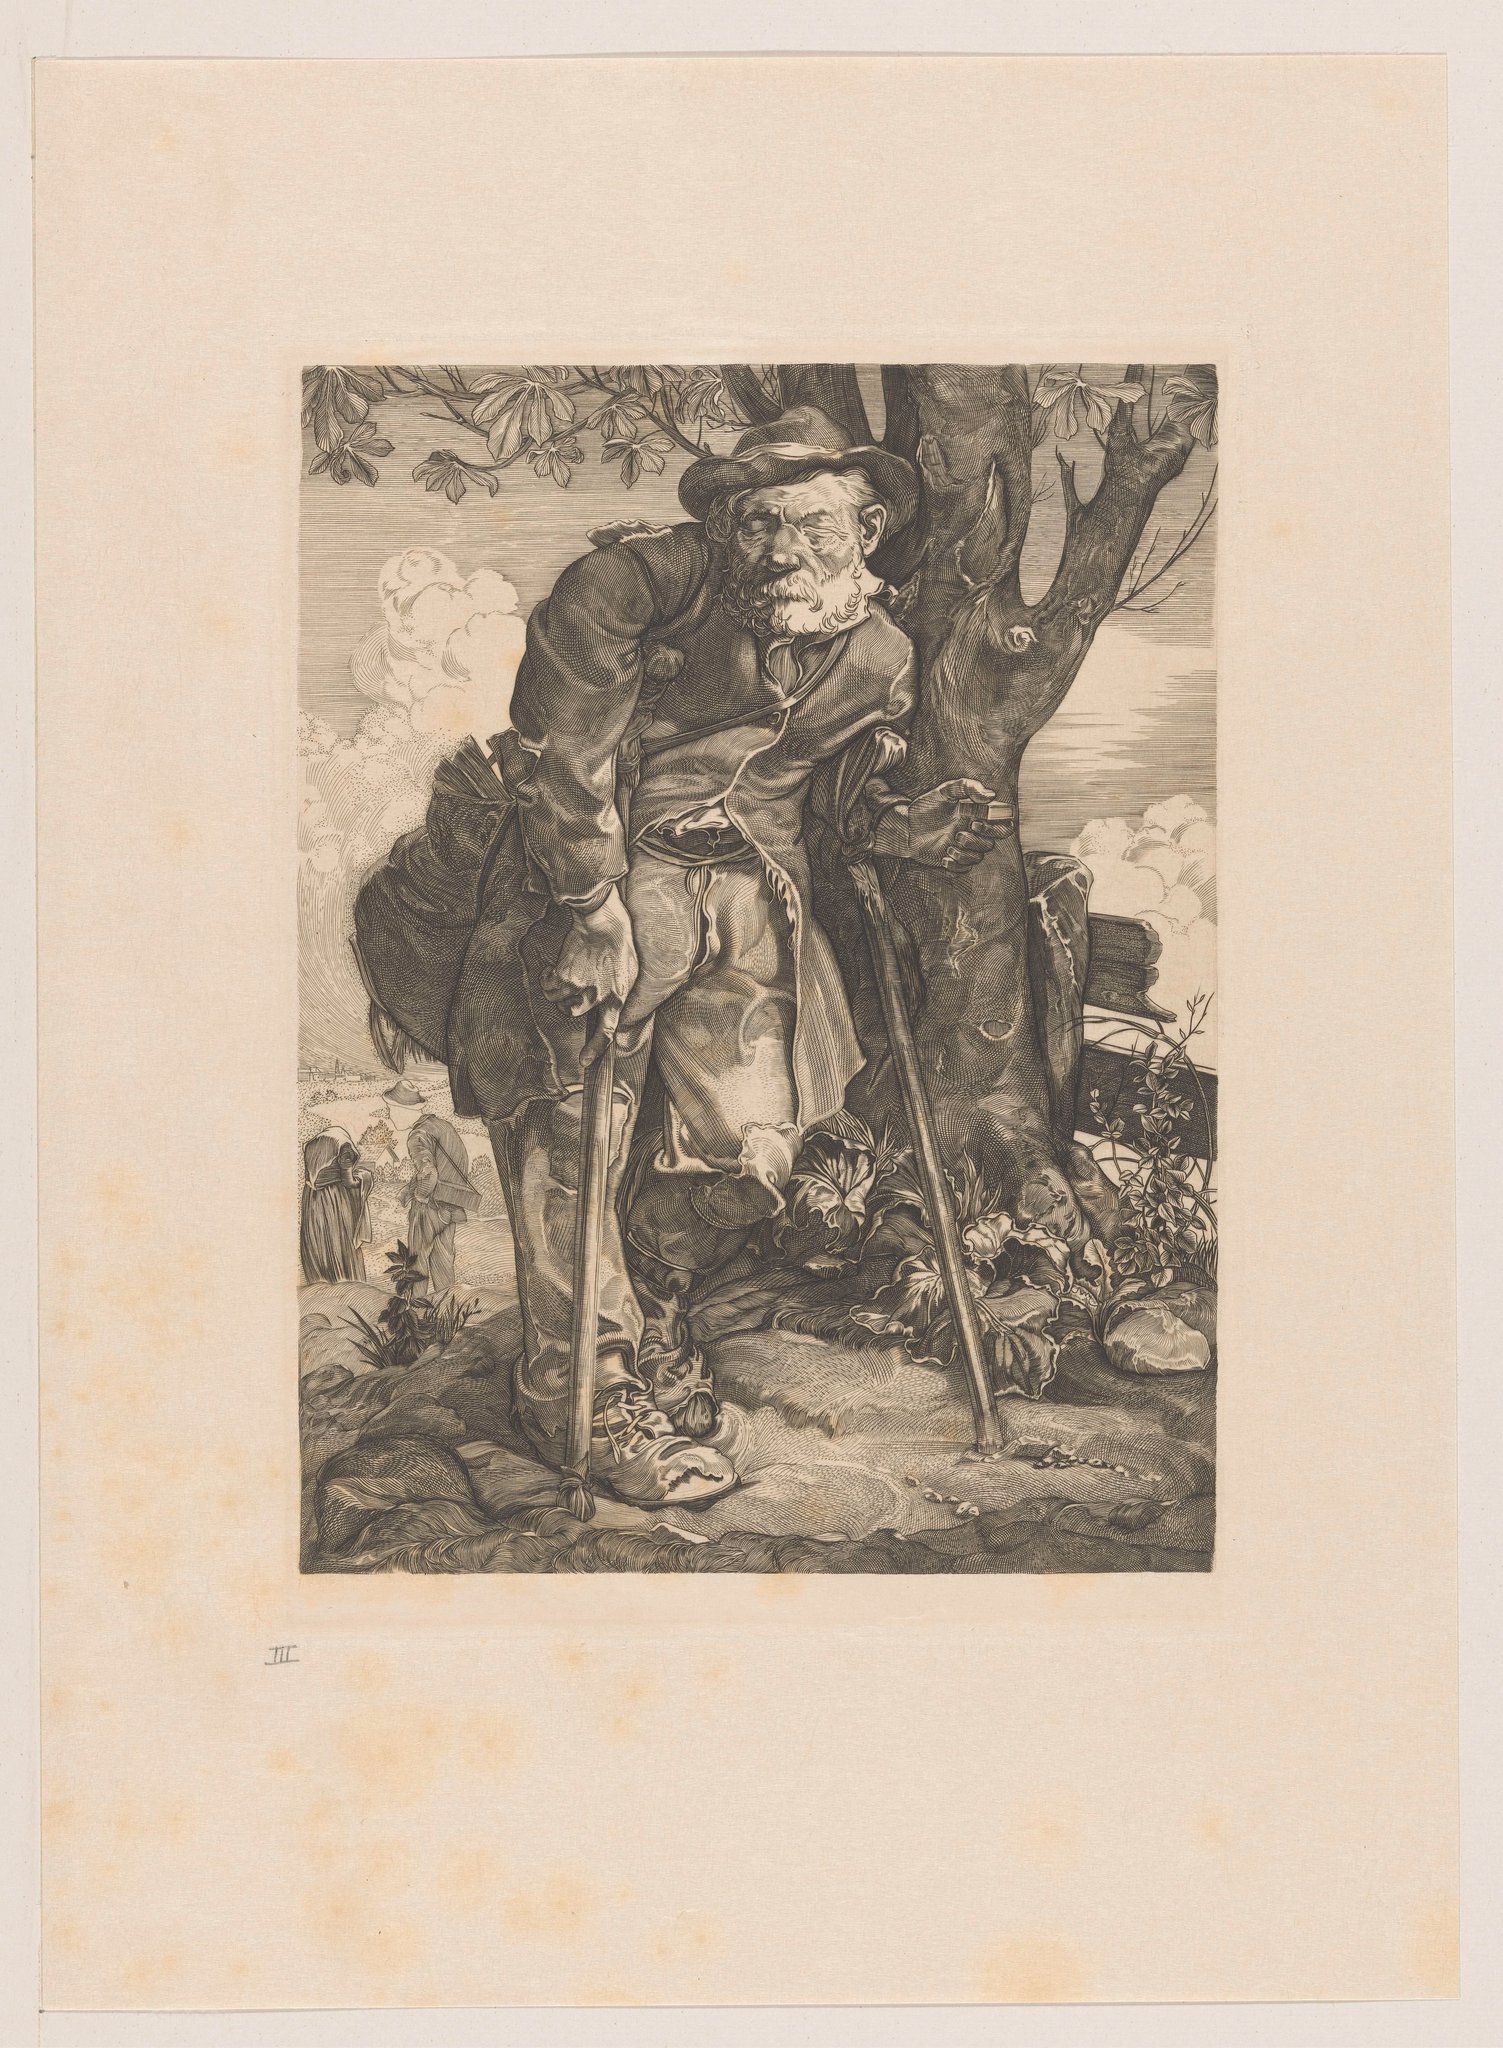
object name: print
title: Landlooper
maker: johannes josephus aarts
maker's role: draughtsman, print maker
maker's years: 1871-1934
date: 1907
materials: paper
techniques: engraving, intaglio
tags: crutches, beggar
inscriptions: collector's mark: Lugt 2166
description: Een bebaarde man met hoed, gekleed in beschadigde, deels herstelde kleren, lopend met twee krukken. In zijn linkerhand een klein, rechthoekig voorwerp. Linksachter hem een man en een vrouw, rechtsachter hem een boom.